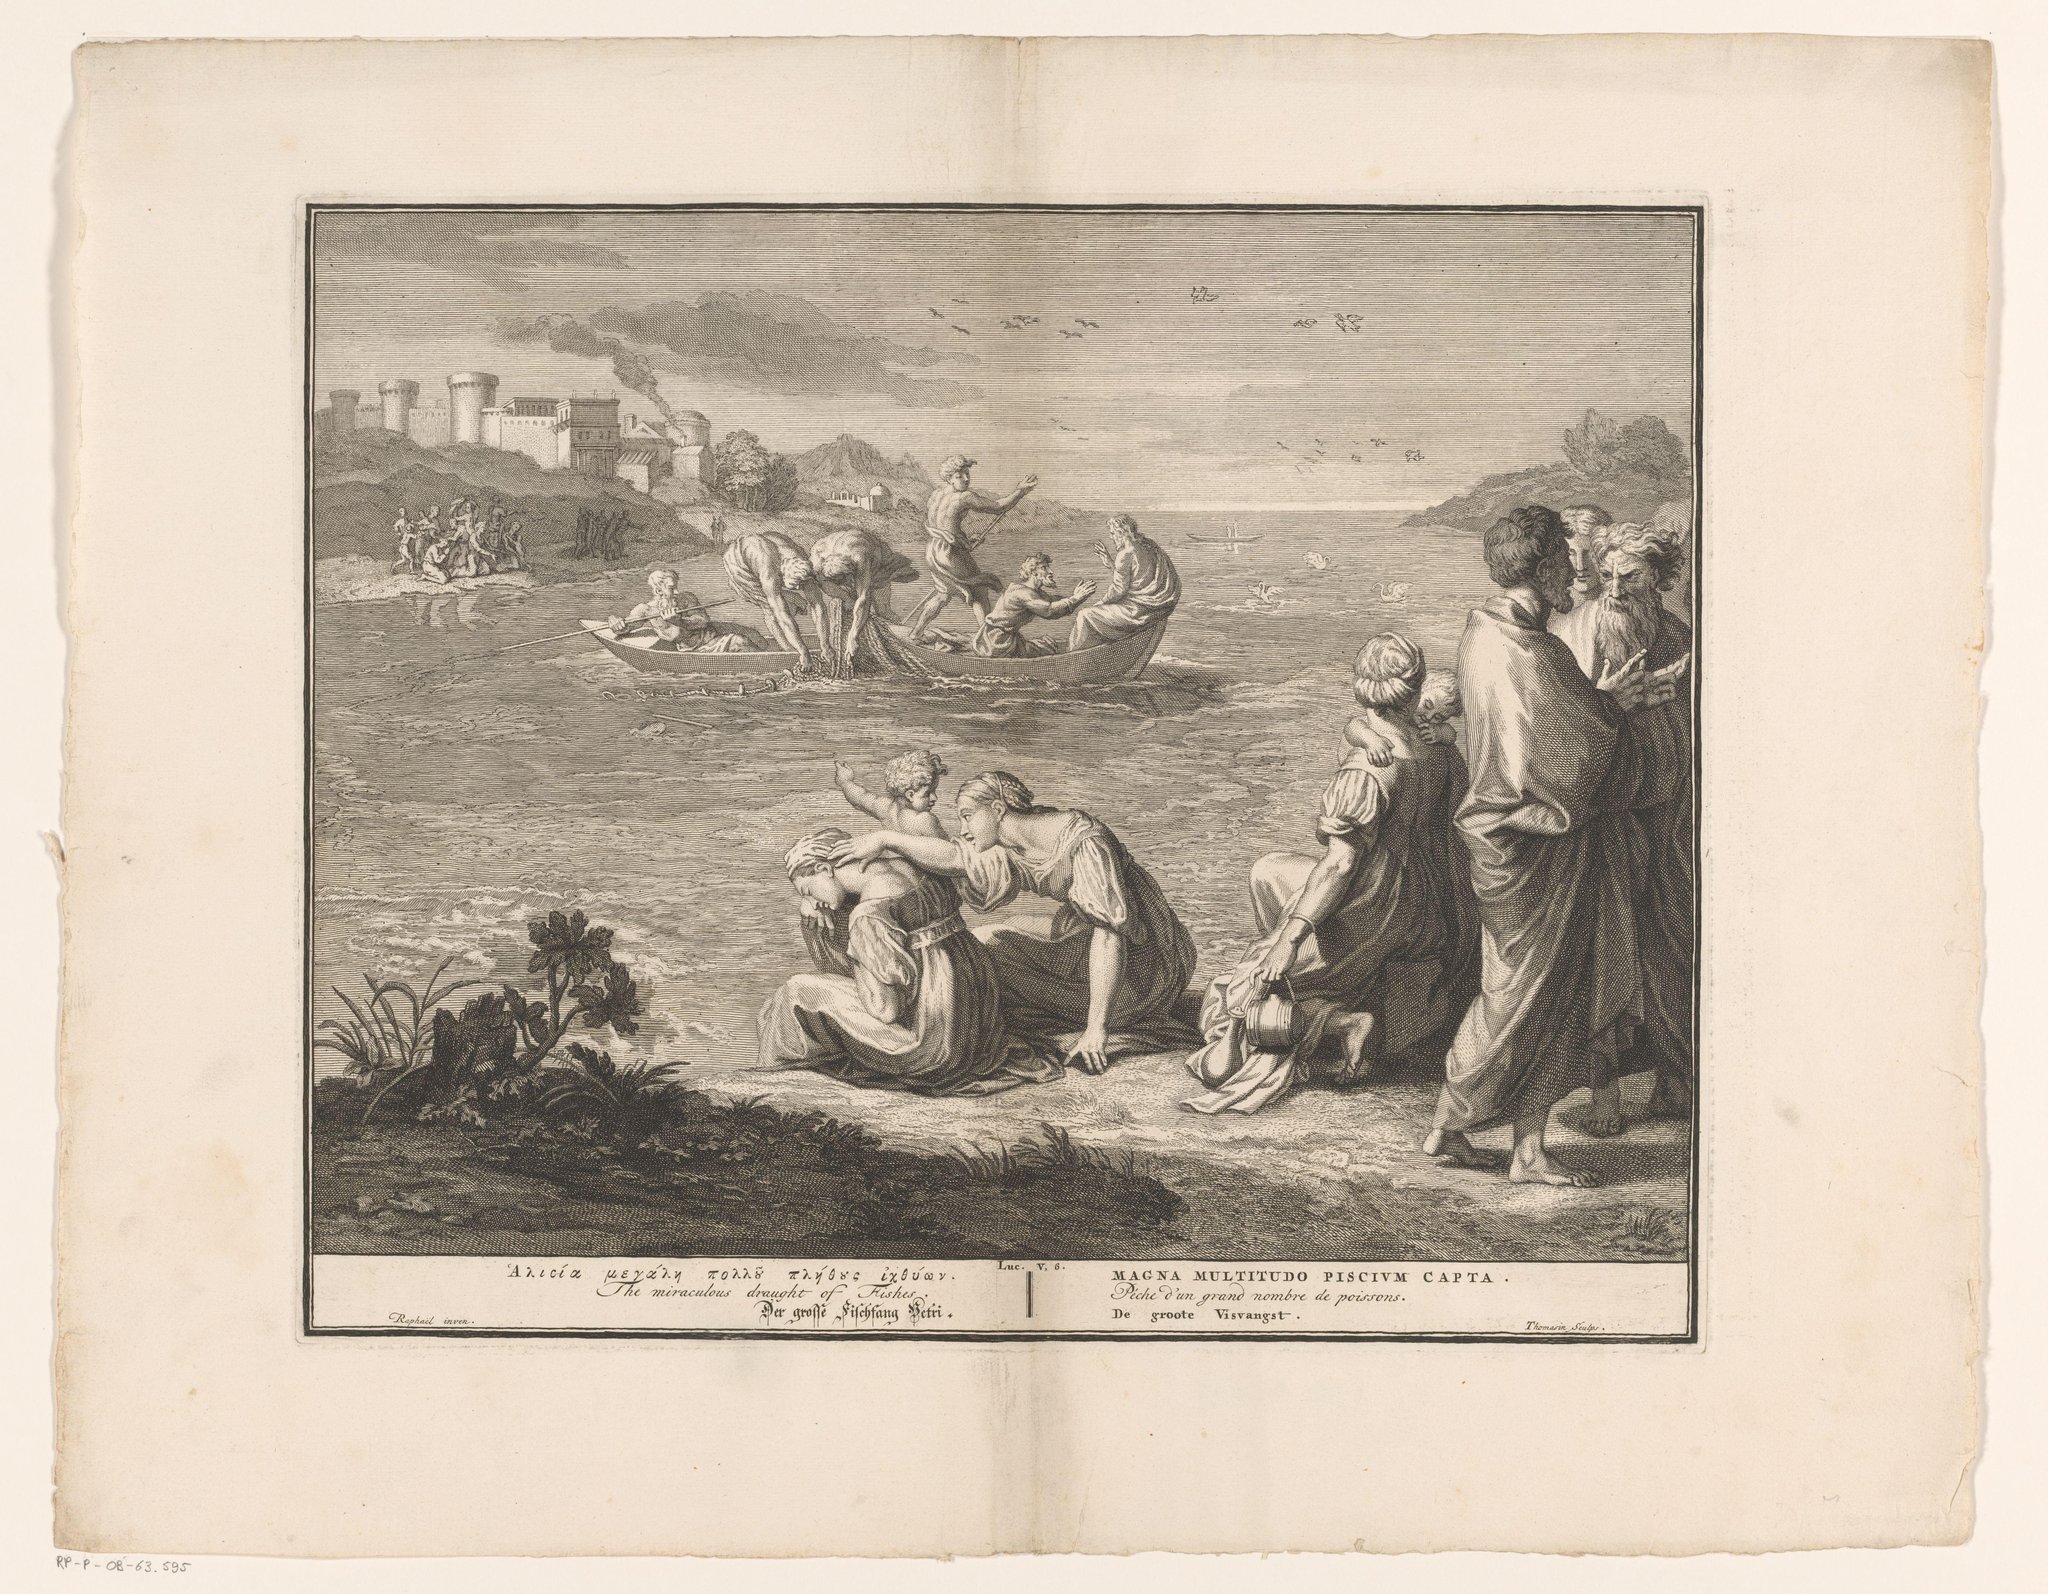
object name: print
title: Wonderbare visvangst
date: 1697-1741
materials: paper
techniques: etching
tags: the miraculous draught of fishes (before the resurrection) on the lake of gennesaret (sea of galilee); james and john helping to bring in the nets (luke 5:1-11)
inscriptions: inscription: ‘Utrechts Fundatie huijs’